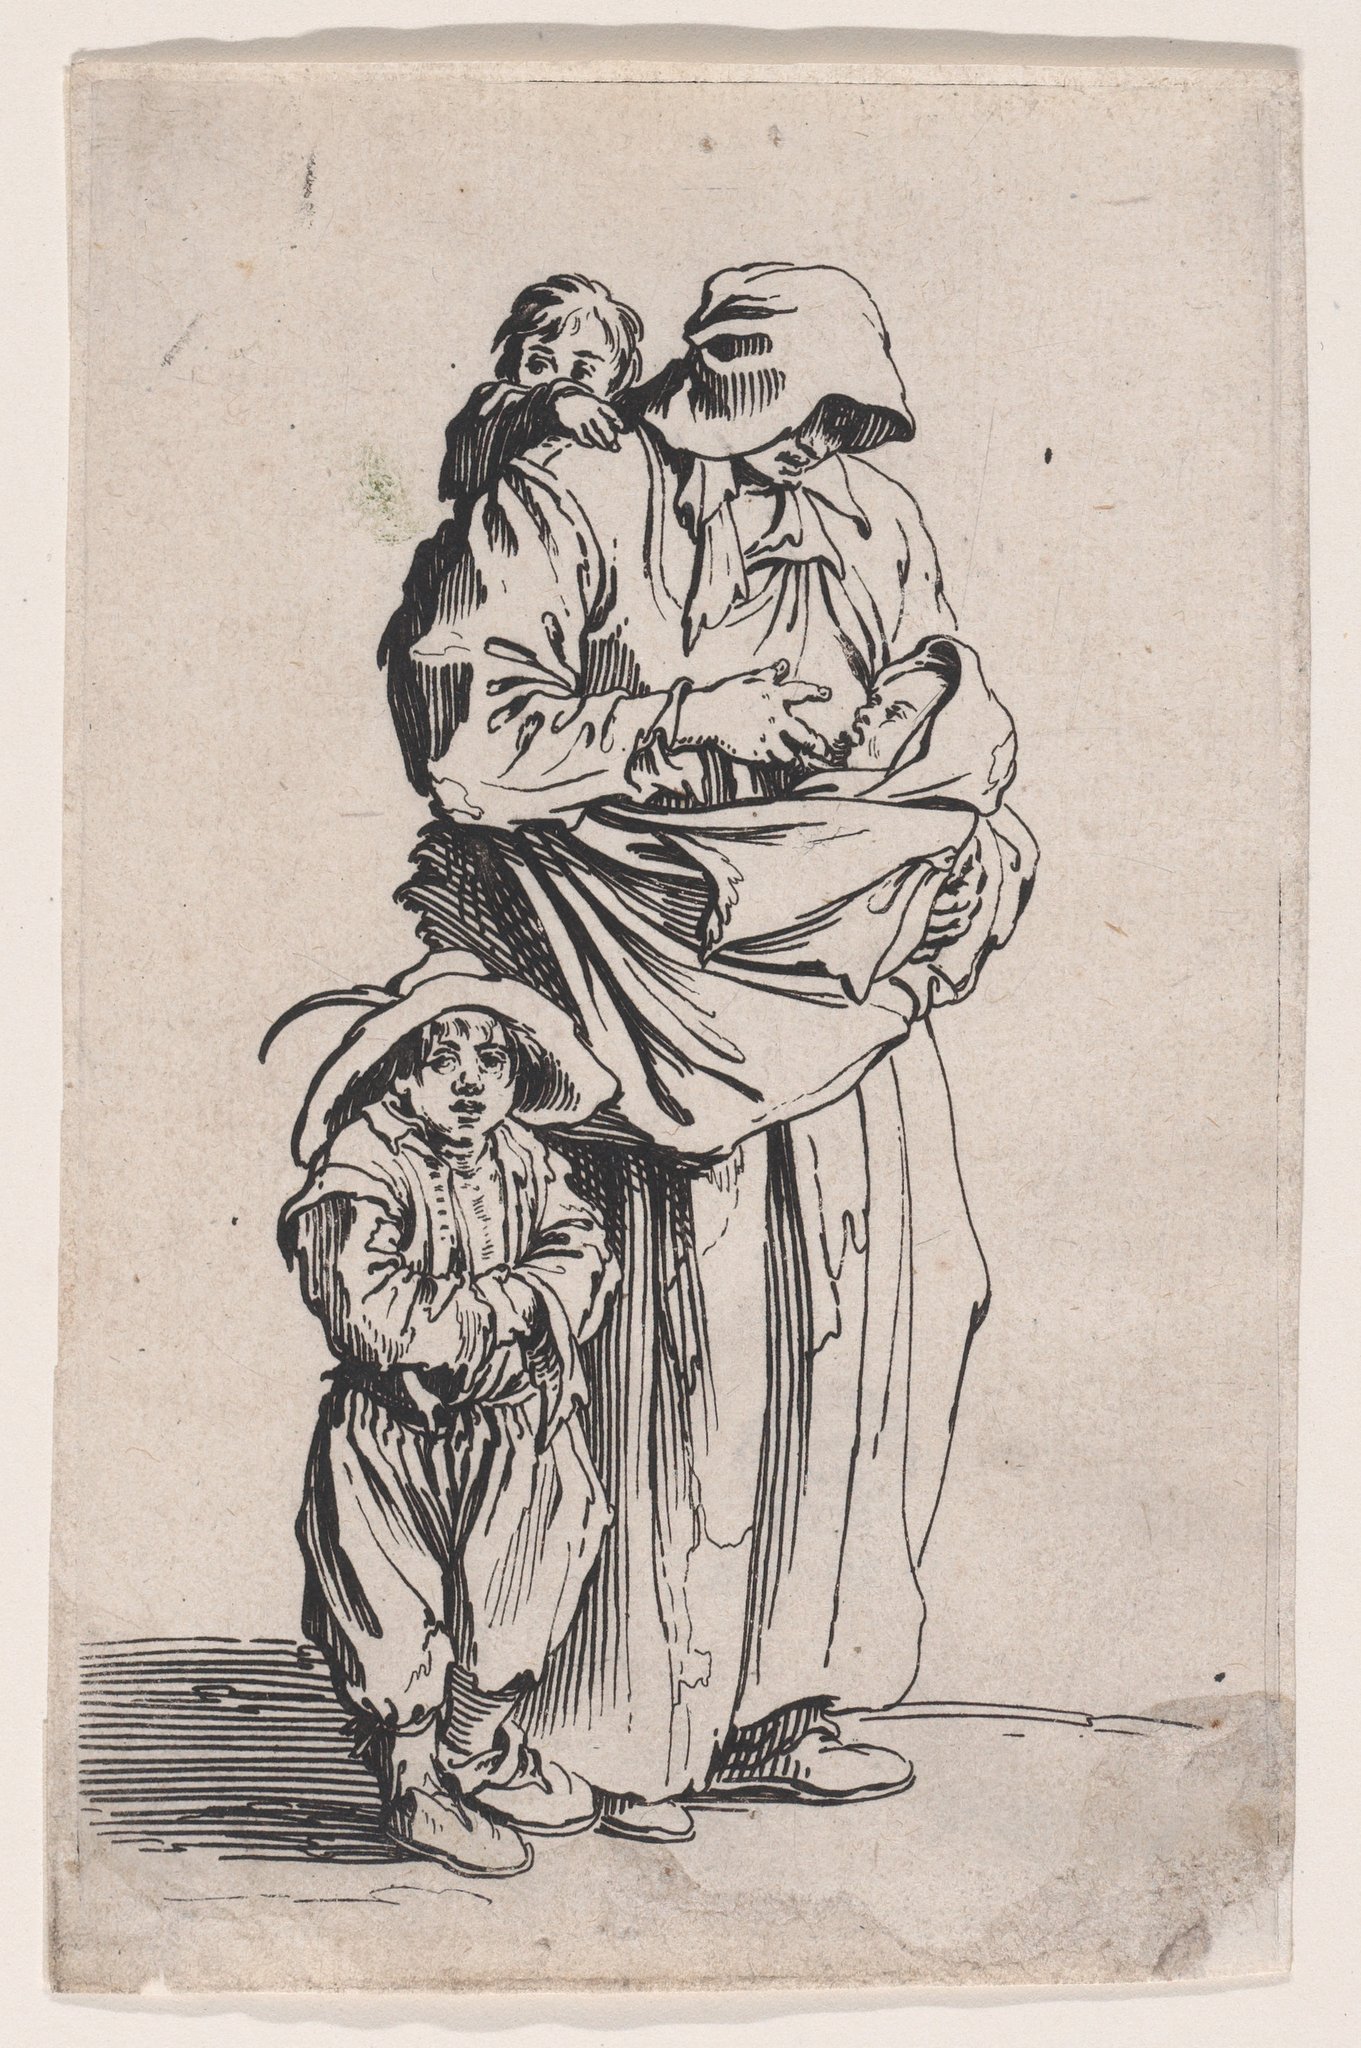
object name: print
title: La Mère et ses Trois Enfans (The Mother and her Three Children), from "Les Gueux suite appelée aussi Les Mendiants, Les Baroni, ou Les Barons" (The Beggars, also called the Barons)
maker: jacques callot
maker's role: artist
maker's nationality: french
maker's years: 1592-1635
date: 1623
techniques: etching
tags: children,infants,mothers,women,nursing